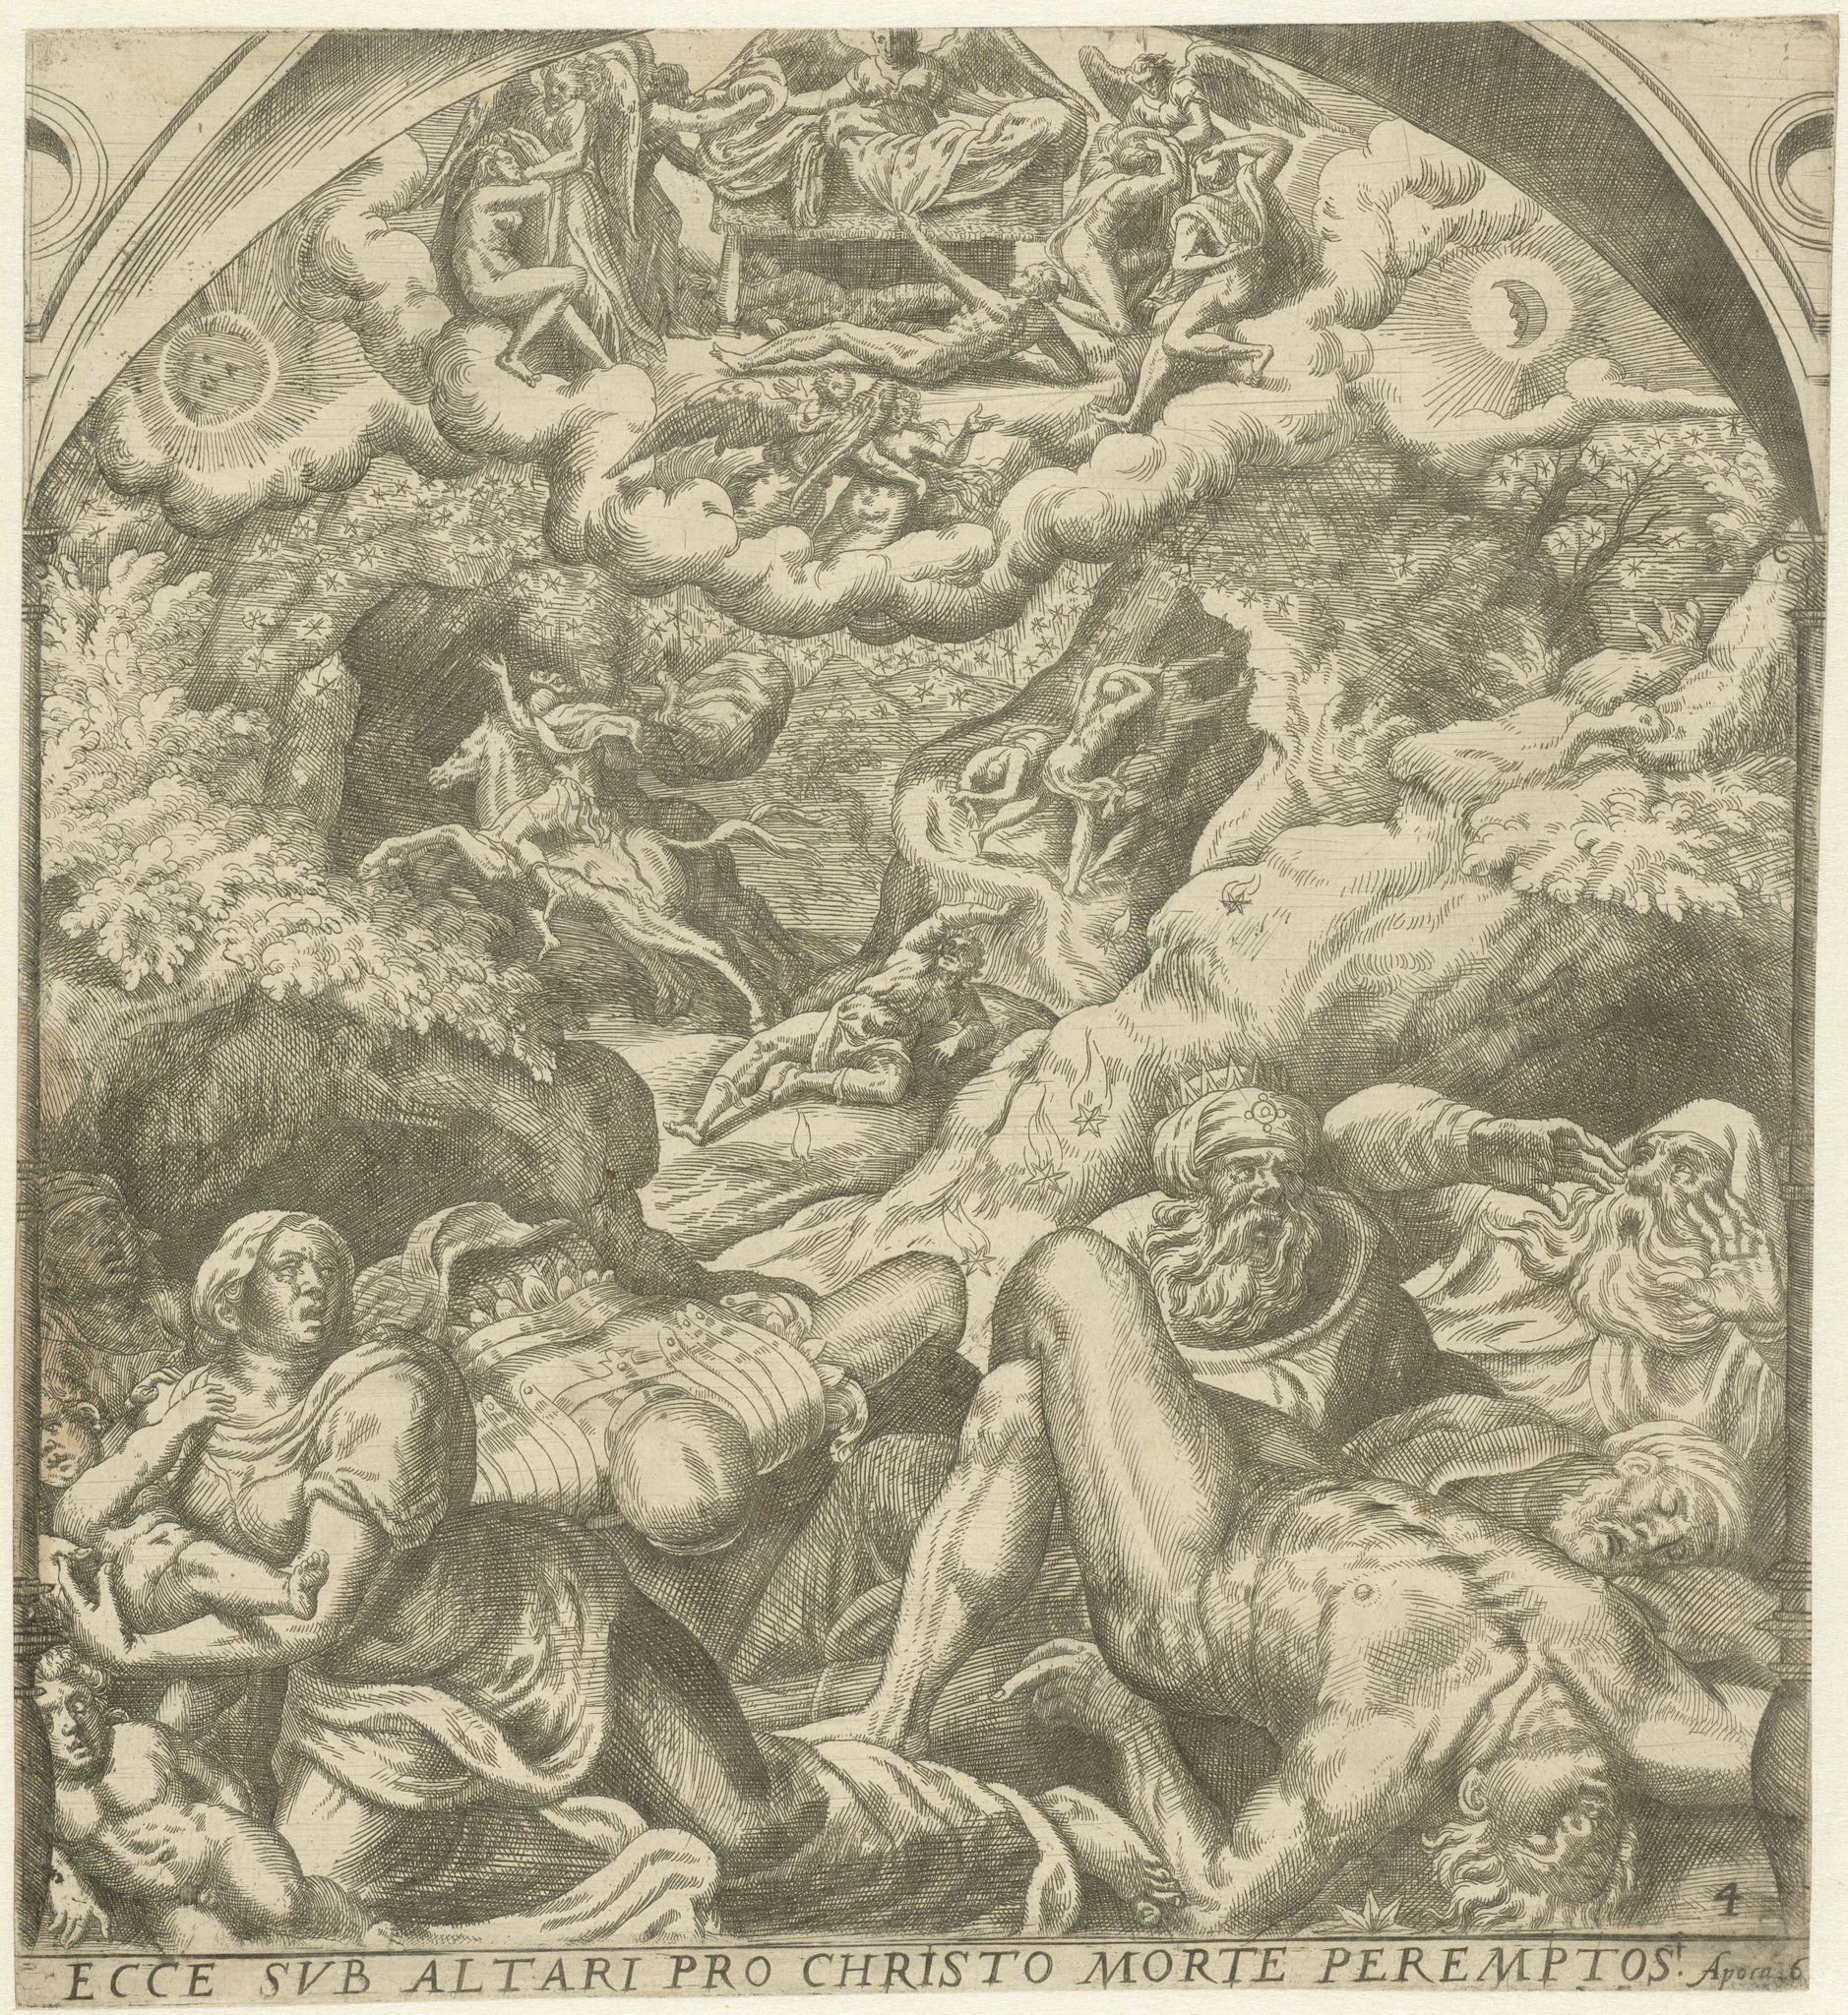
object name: print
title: Openbaring van Johannes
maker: gerard van groeningen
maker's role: draughtsman, painter, print maker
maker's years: 1515-1599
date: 1563-1574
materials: paper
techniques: engraving, etching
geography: antwerp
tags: opening of the sixth seal: a great earthquake, the sun turns black, the moon red as blood, and the stars fall on earth; mankind hiding in caves, opening of the fifth seal: white robes are given to (the souls of) the martyrs under the altar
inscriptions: collector's mark: Lugt 2228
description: Het verbreken van het zesde zegel. Aardbevingen en overstromingen teisteren de wereld. Vrouwen, kinderen, soldaten en koningen vluchten voor het onheil. De maan en de zon staan hoog aan de hemel en de sterren vallen uit de hemel op aarde (Op. 6: 12-17). In de lucht een altaar waaronder de eerste christelijke martelaren. Ze trekken witte gewaden aan die zijn aangereikt door engelen (Op. 6: 9-12).